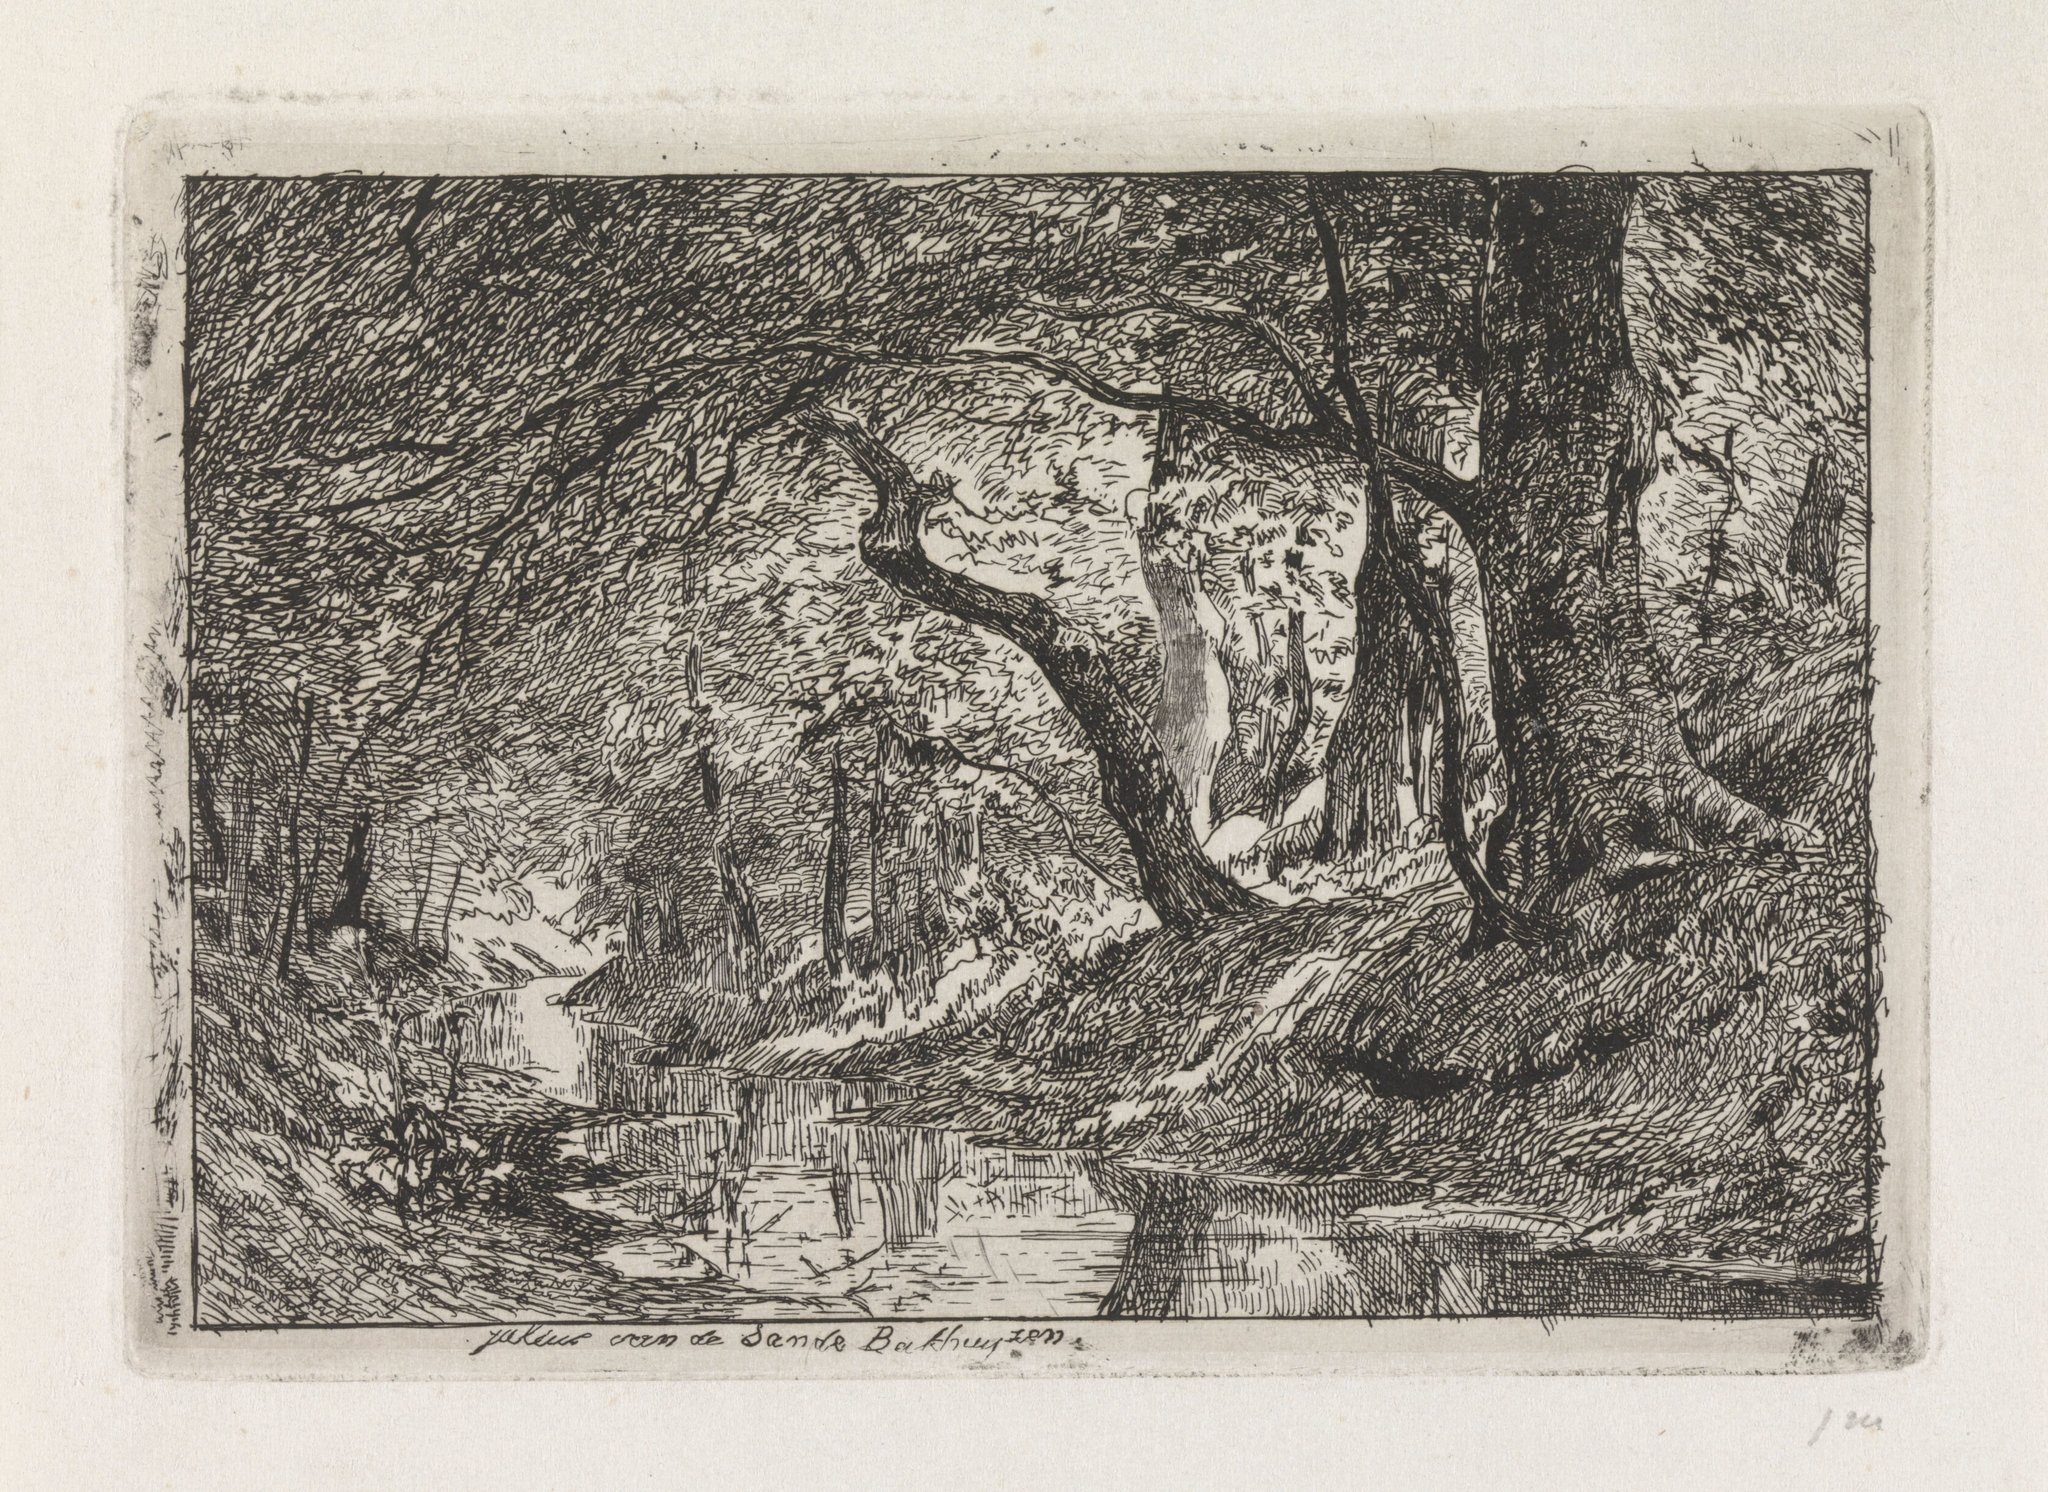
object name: print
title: Boslandschap met beek en bomen op oever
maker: julius jacobus van de sande bakhuyzen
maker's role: draughtsman, painter, print maker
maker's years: 1835-1925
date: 1845-1885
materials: paper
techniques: drypoint, etching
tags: forest, wood, brook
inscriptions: collector's mark: Lugt 2228